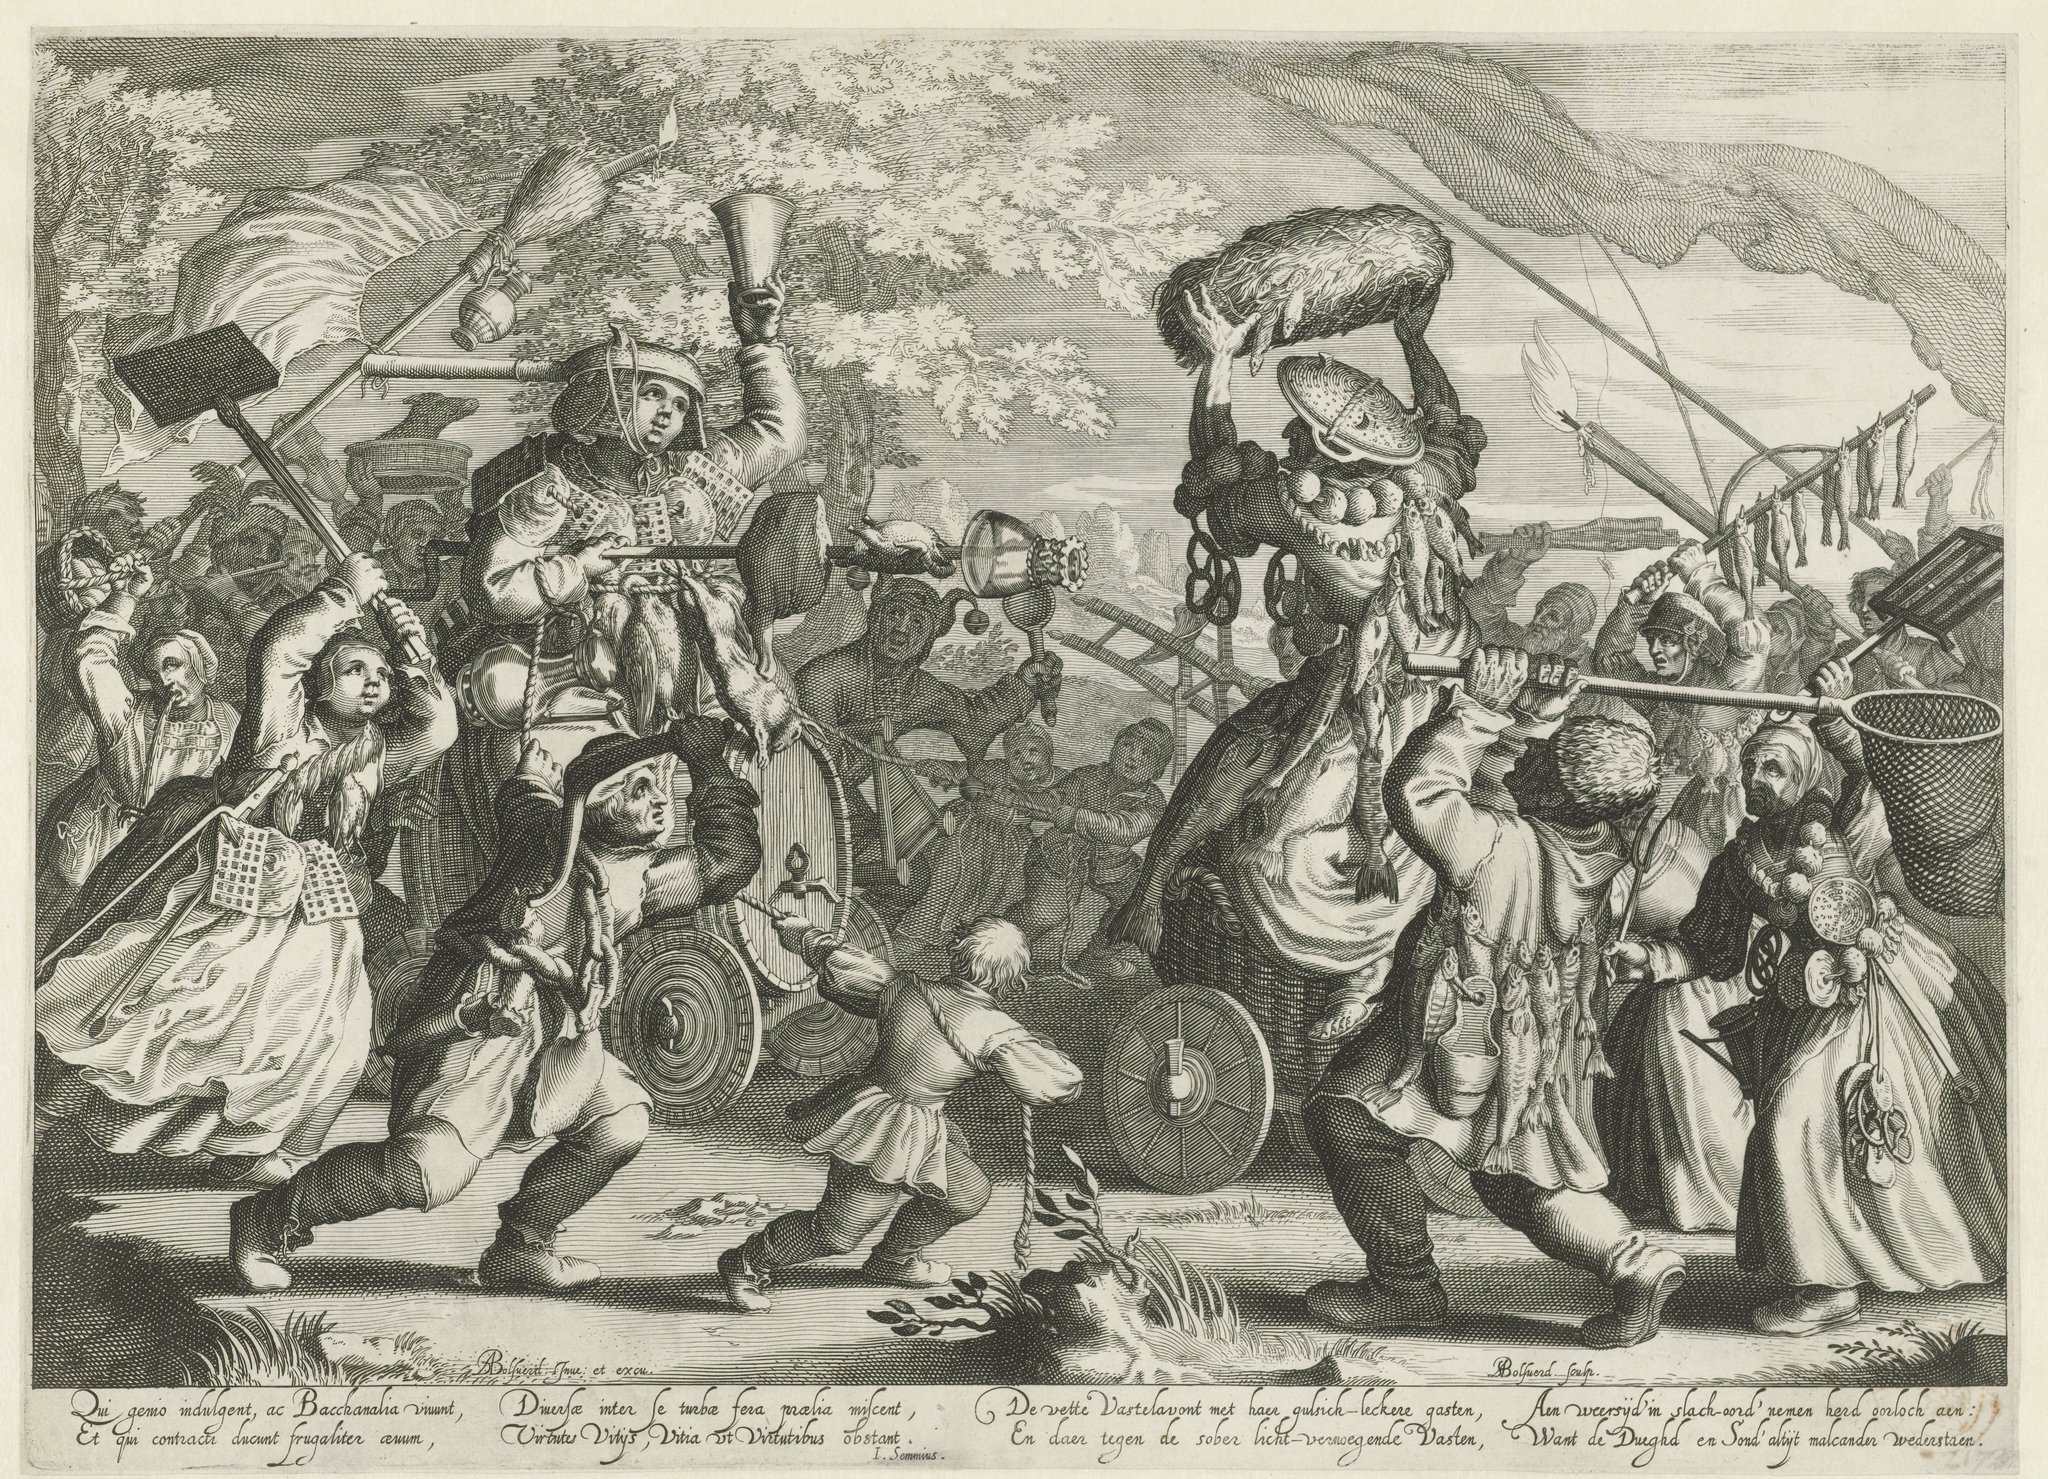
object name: print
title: Strijd tussen vastenavond en vasten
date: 1596-1659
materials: paper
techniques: engraving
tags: fat and thin (human types), fasting ~ roman religion, shrove tuesday, 'mardi gras' ~ non-liturgical celebrations of carnival, fighting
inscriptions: collector's mark: Lugt 240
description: Twee groepen mensen vertegenwoordigen vastenavond en vasten die tegen elkaar strijden. Aan de zijde van vastenavond tonen de weldoorvoede deelnemers hun zondige gewoonten van gulzig eten en drinken, ze zijn behangen met etenswaren zoals worsten, wafels, pannekoeken, jachtbuit en drinkkannen. Als wapens worden onder andere een wafelijzer en allerlei huisraad. Een spit met op de punt een roemer wordt gehanteerd door een dikke figuur, zwaaiend met een drinkbeker en zittend op een bierton. Hun tegenstanders die hun deugd zoeken in het vasten moeten het stellen met een kariger maal van vis en krakelingen. Zij zwaaien dreigend met een visnet en rooster. Onder de voorstelling staat een vers in Latijn en de nederlandse vertaling die wijzen op de strijd tussen deugd en zonde.